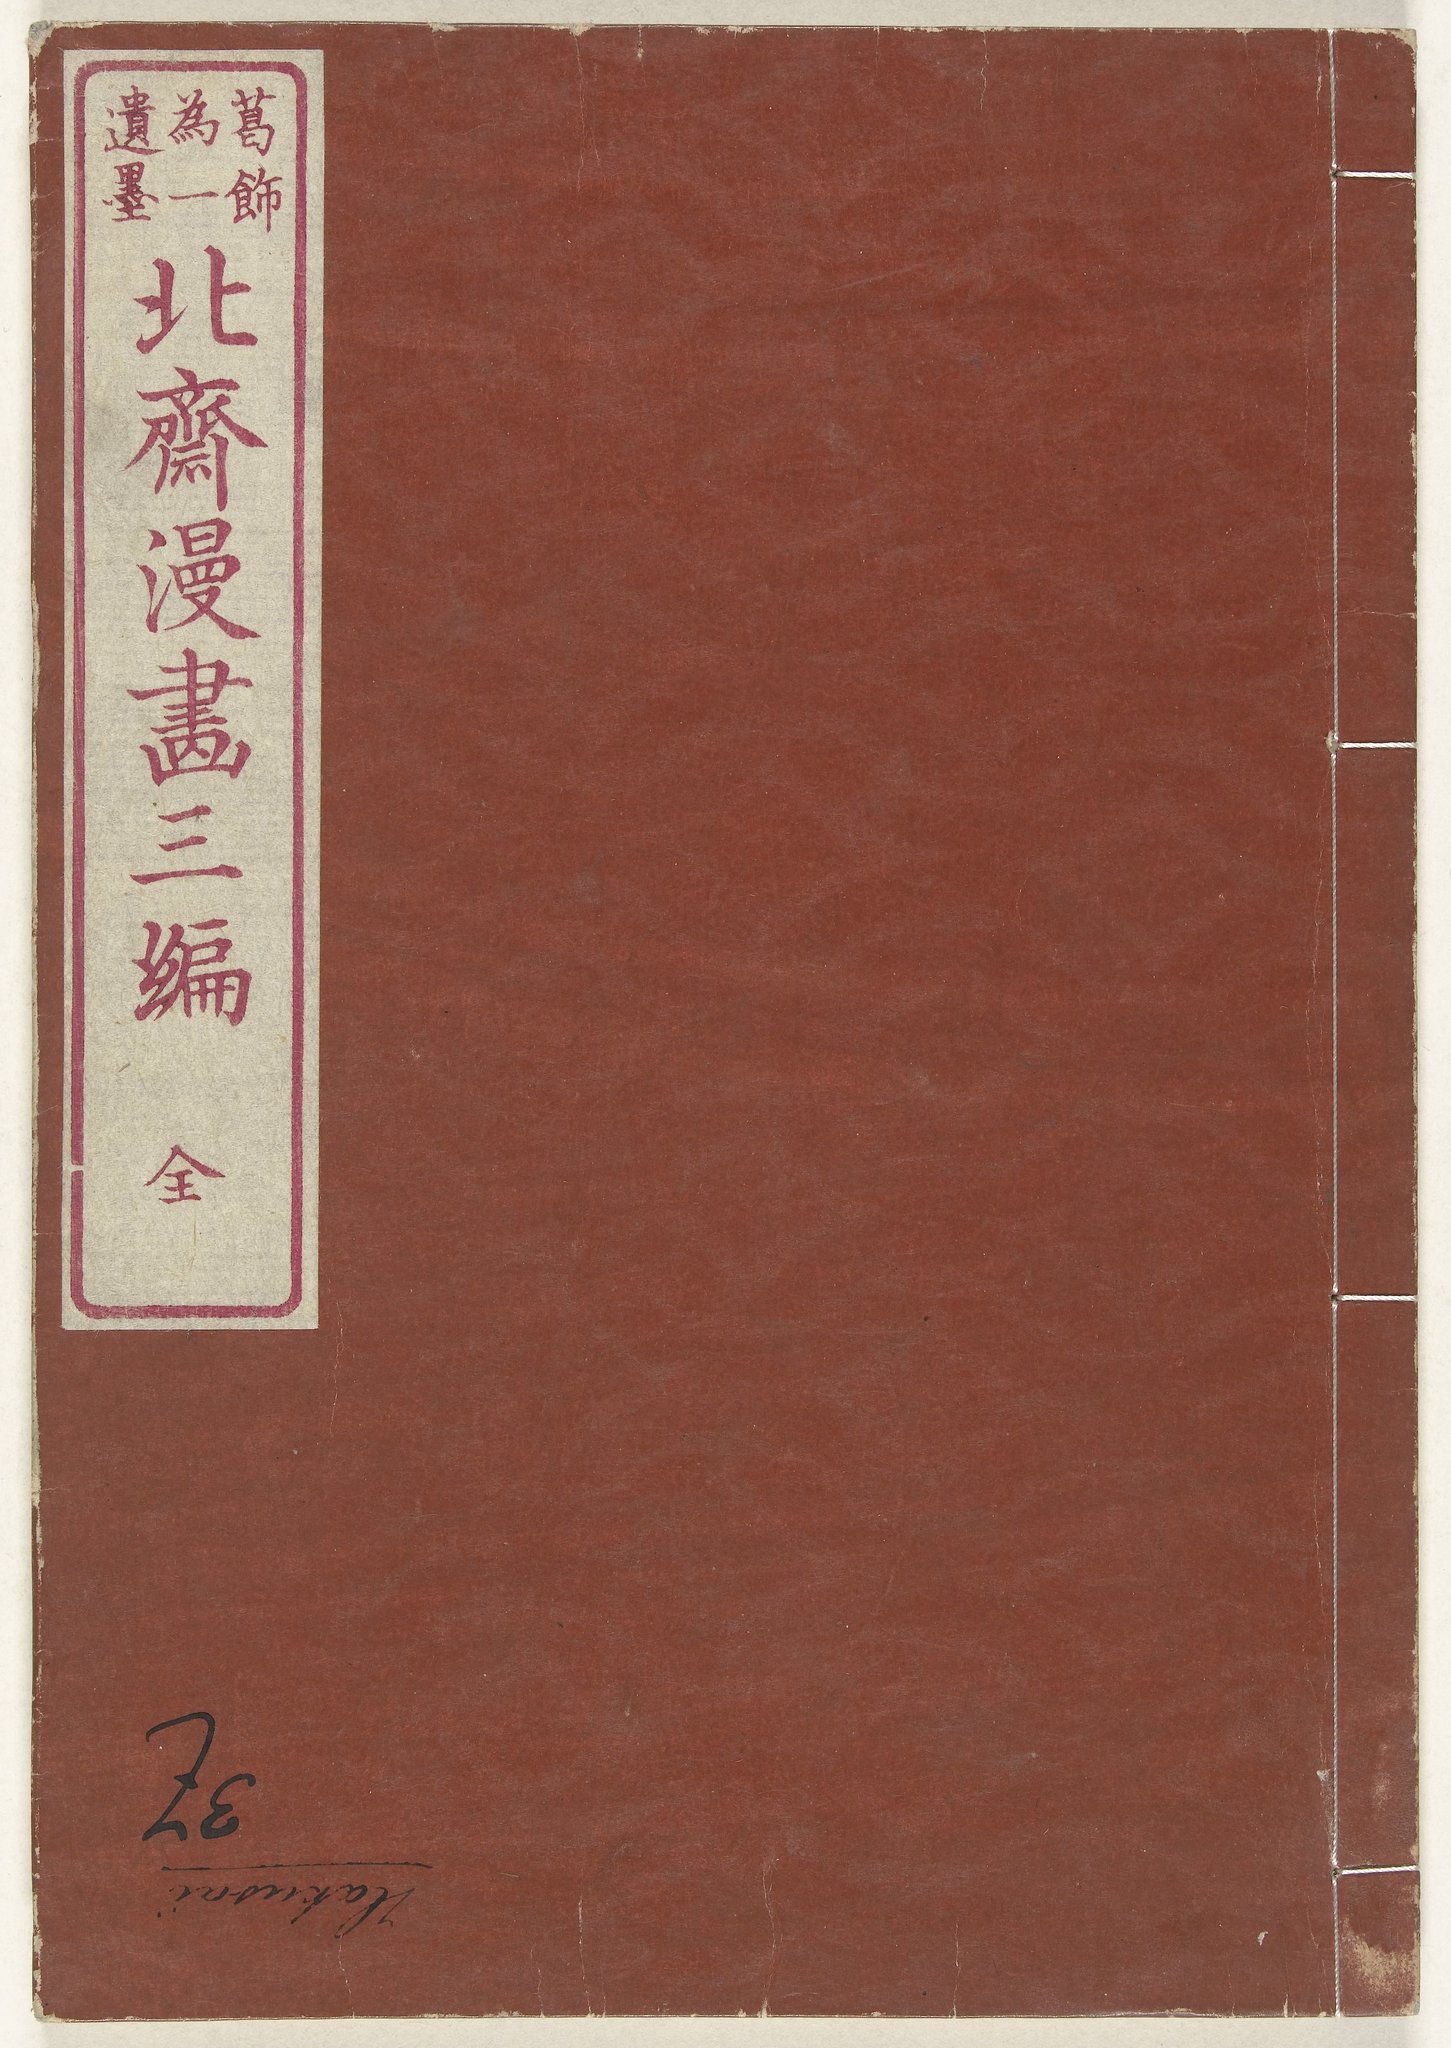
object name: book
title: Schetsen van Hokusai - deel 3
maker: katsushika hokusai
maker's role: draughtsman, print maker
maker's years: 1760-1849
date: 1878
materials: paper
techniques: woodcut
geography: japan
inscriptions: collector's mark: ‘Rijksschool voor kunstnijverheid’ Lugt 3937, collector's mark: Lugt 2228